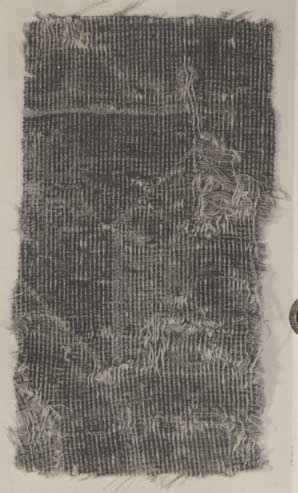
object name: carpet fragment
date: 1501-1600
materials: wool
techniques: asymmetrically knotted pile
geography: egypt